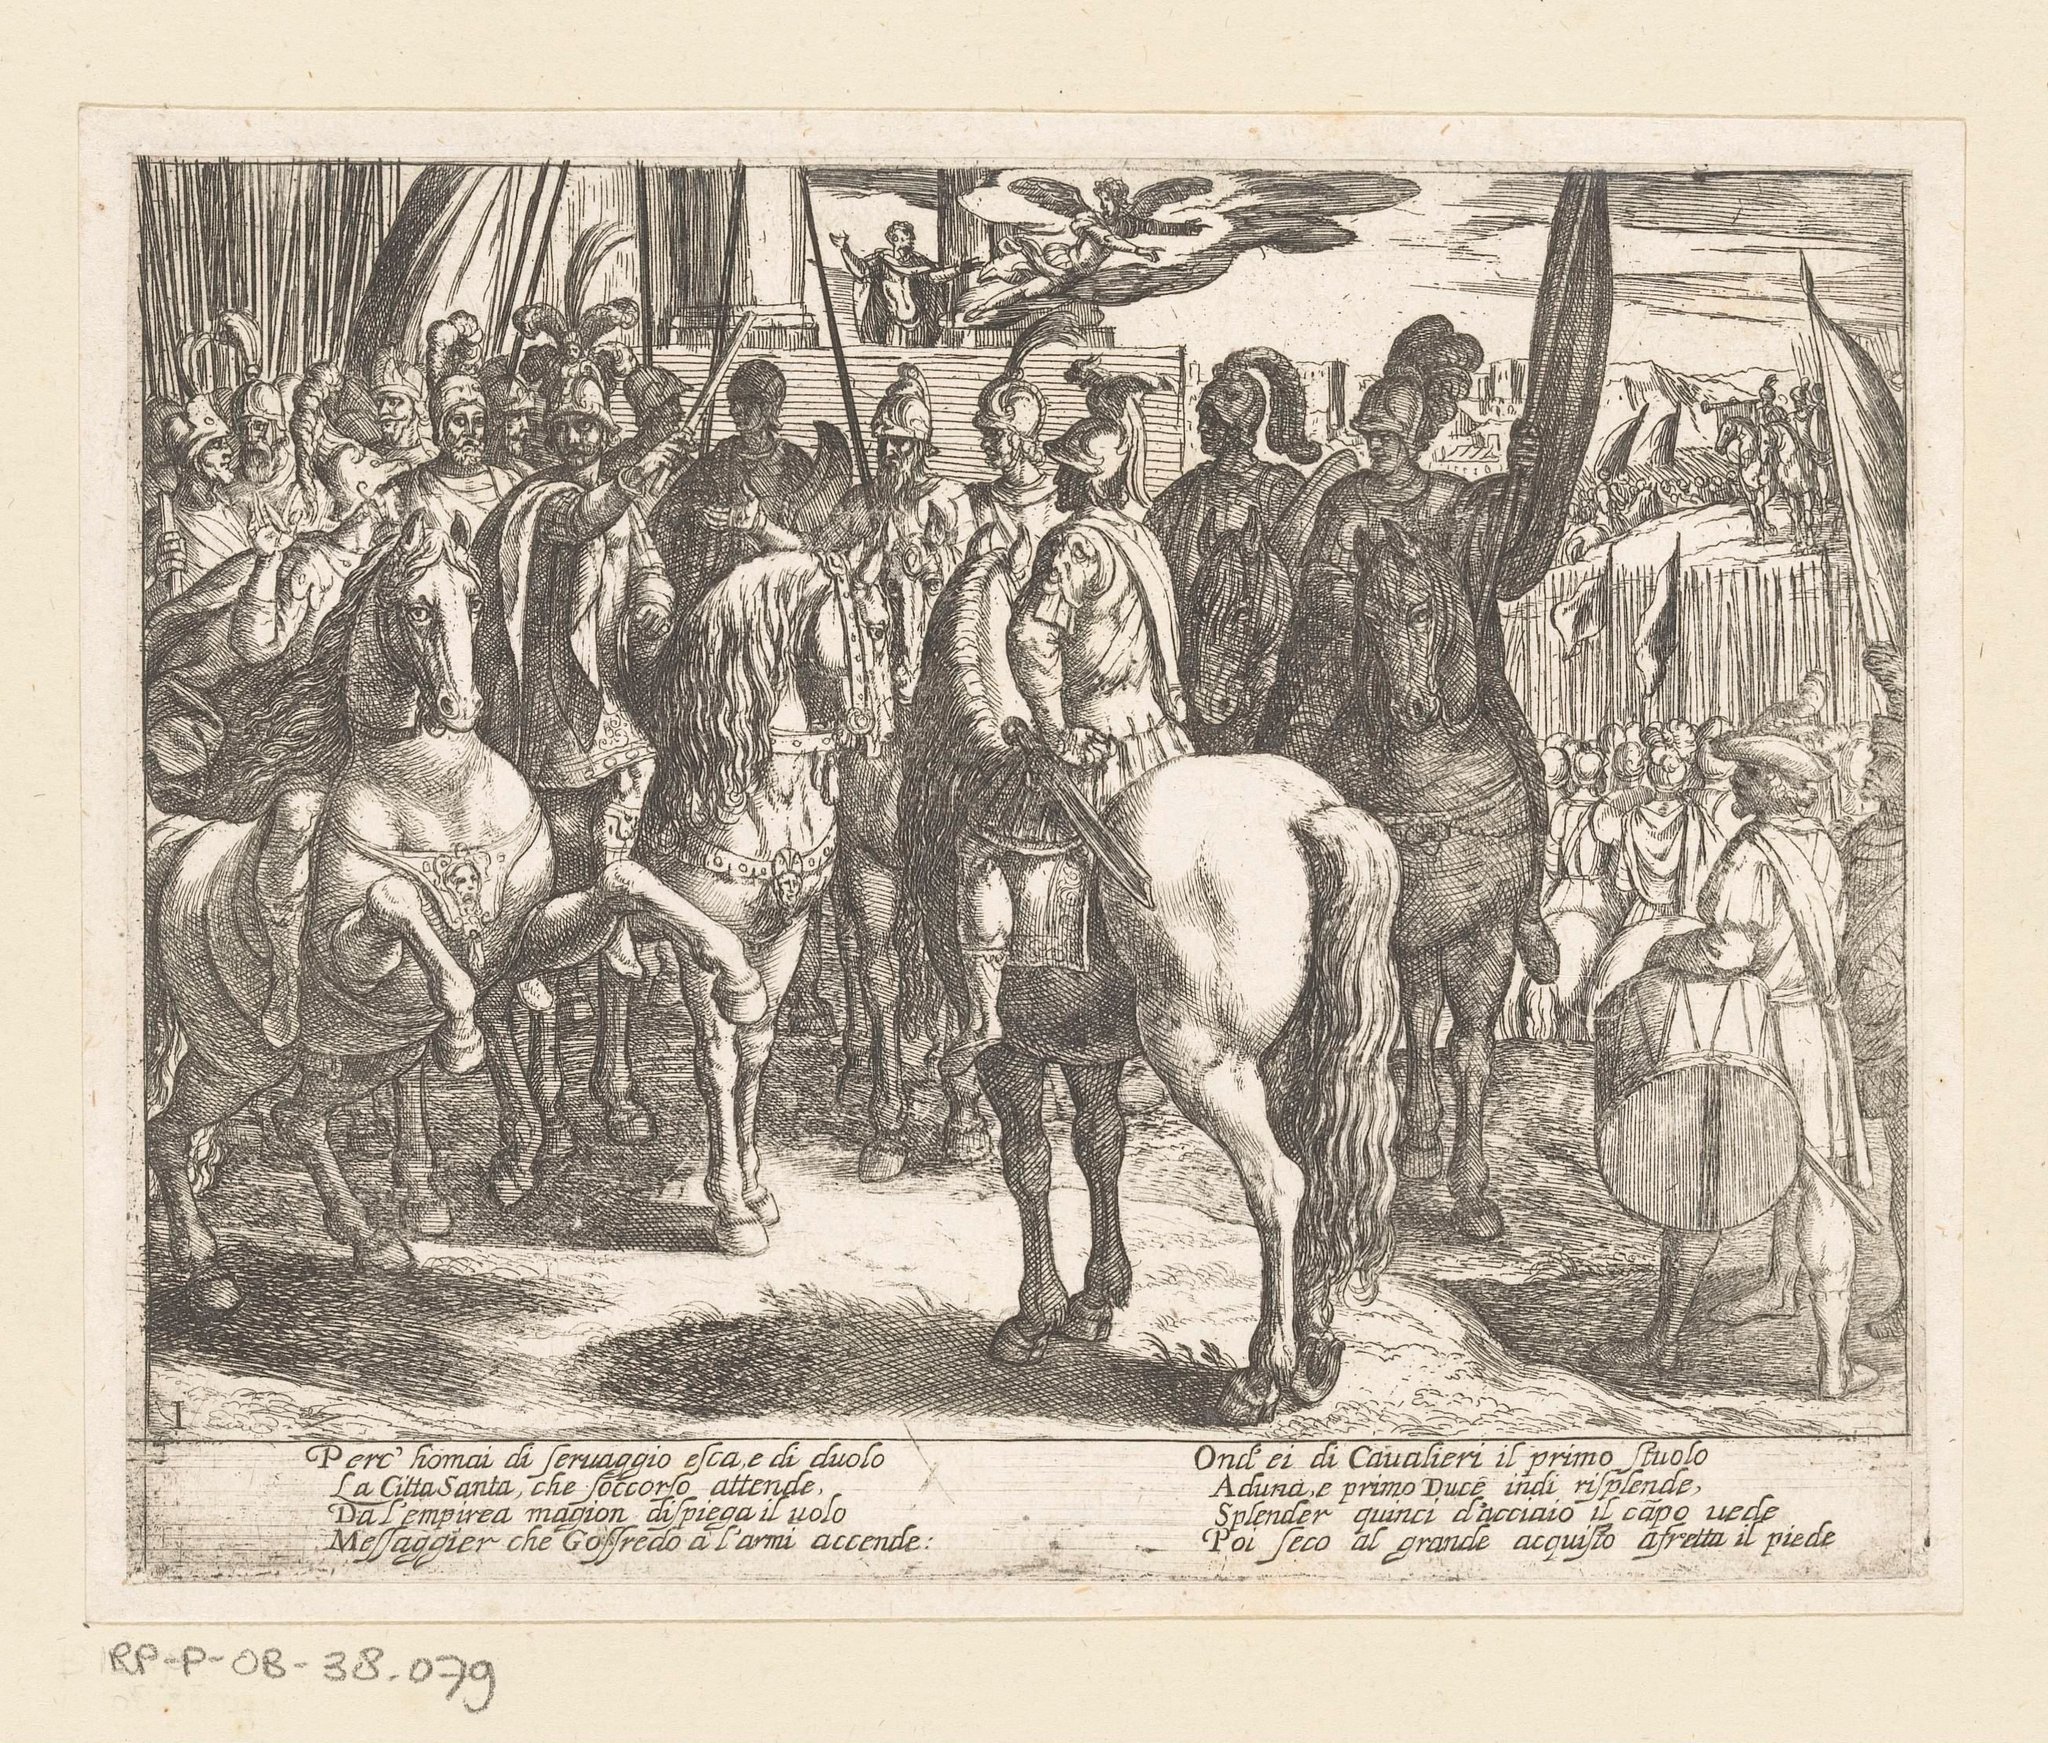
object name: print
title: Illustratie bij Canto I van Tasso's 'Gerusalemme Liberata'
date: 1565-1630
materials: paper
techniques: etching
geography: italy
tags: godfrey of bouillon, militant proselytizing: religious war, crusade, etc., (scenes from) specific works of literature: tasso, gerusalemme liberata, knight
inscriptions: collector's mark: Lugt 240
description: Deze prent maakt deel uit van een reeks van twintig prenten (+ opdracht) met voorstellingen van scènes uit Tasso's 'Jeruzalem verlost', een episch gedicht geschreven door de Italiaanse dichter Torquato Tasso en voor het eerst gepubliceerd in 1581. Het verhaal vertelt grotendeels in fictie over de Eerste Kruistocht waarin de christenen, geleid door Godfried van Bouillon, de strijd aangaan met de moslims om het Beleg van Jeruzalem.